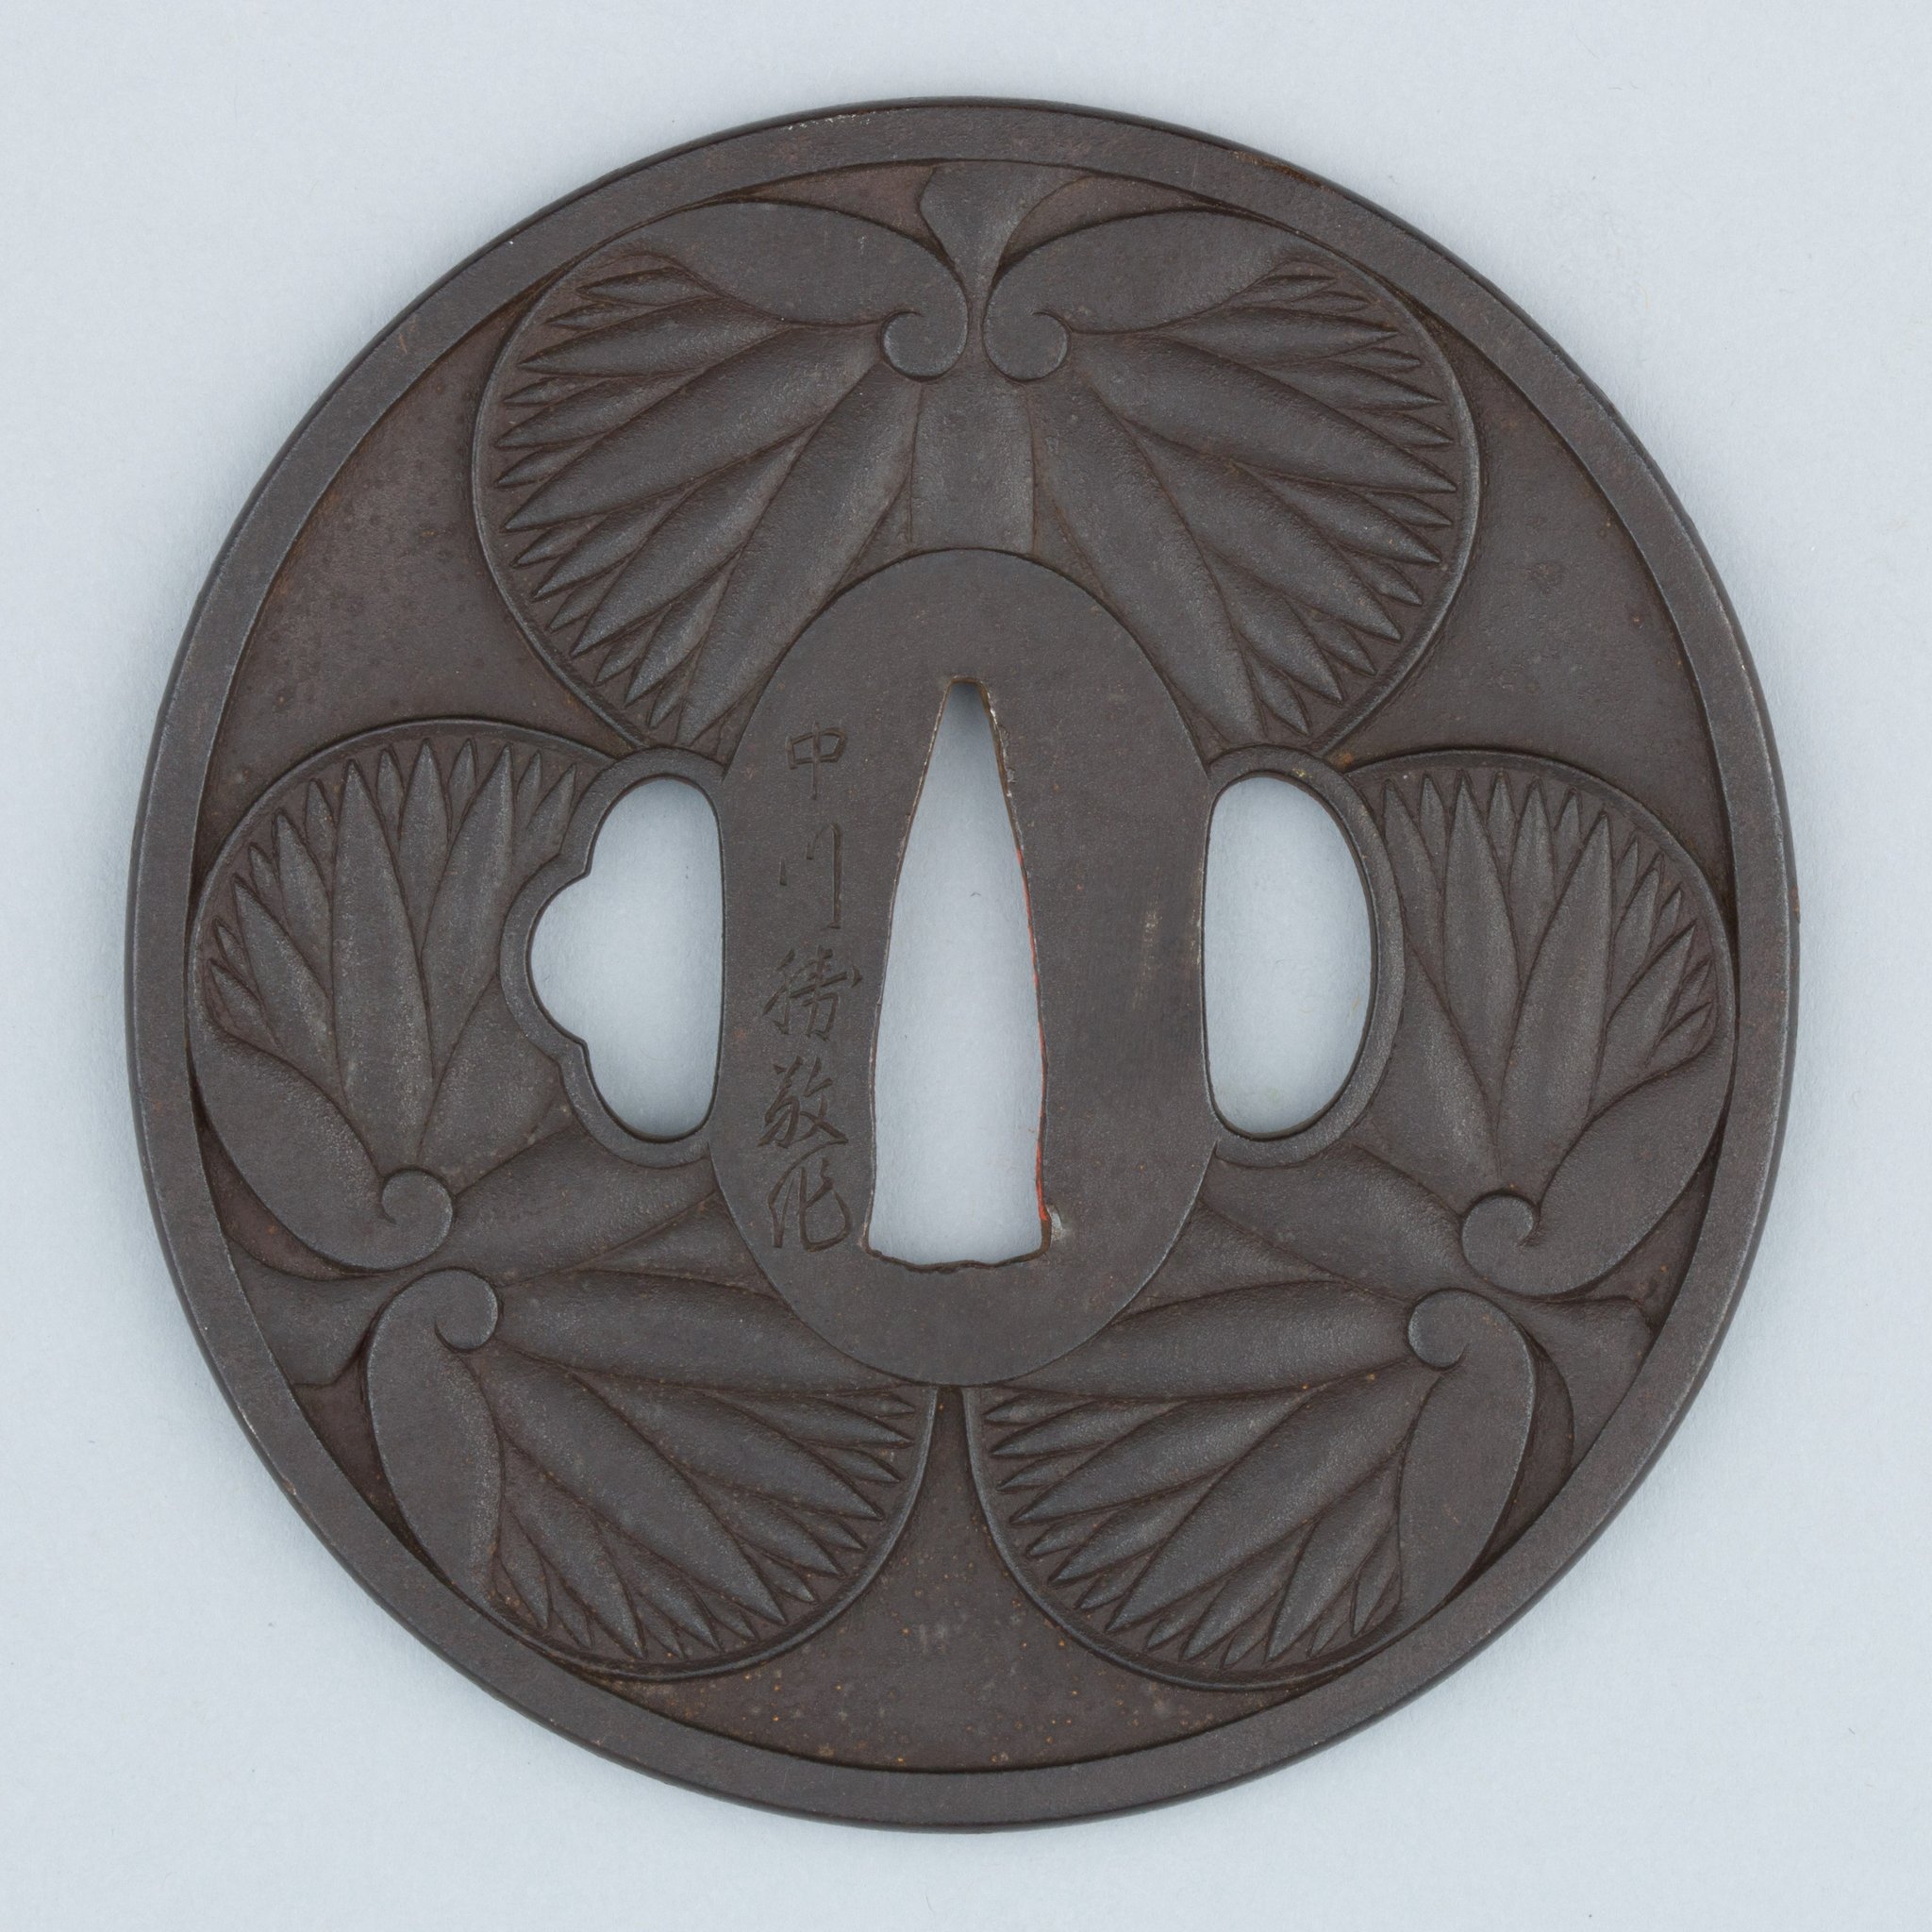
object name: sword guard tsuba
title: Sword Guard (Tsuba)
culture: japanese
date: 1615-1868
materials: copper, iron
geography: japan